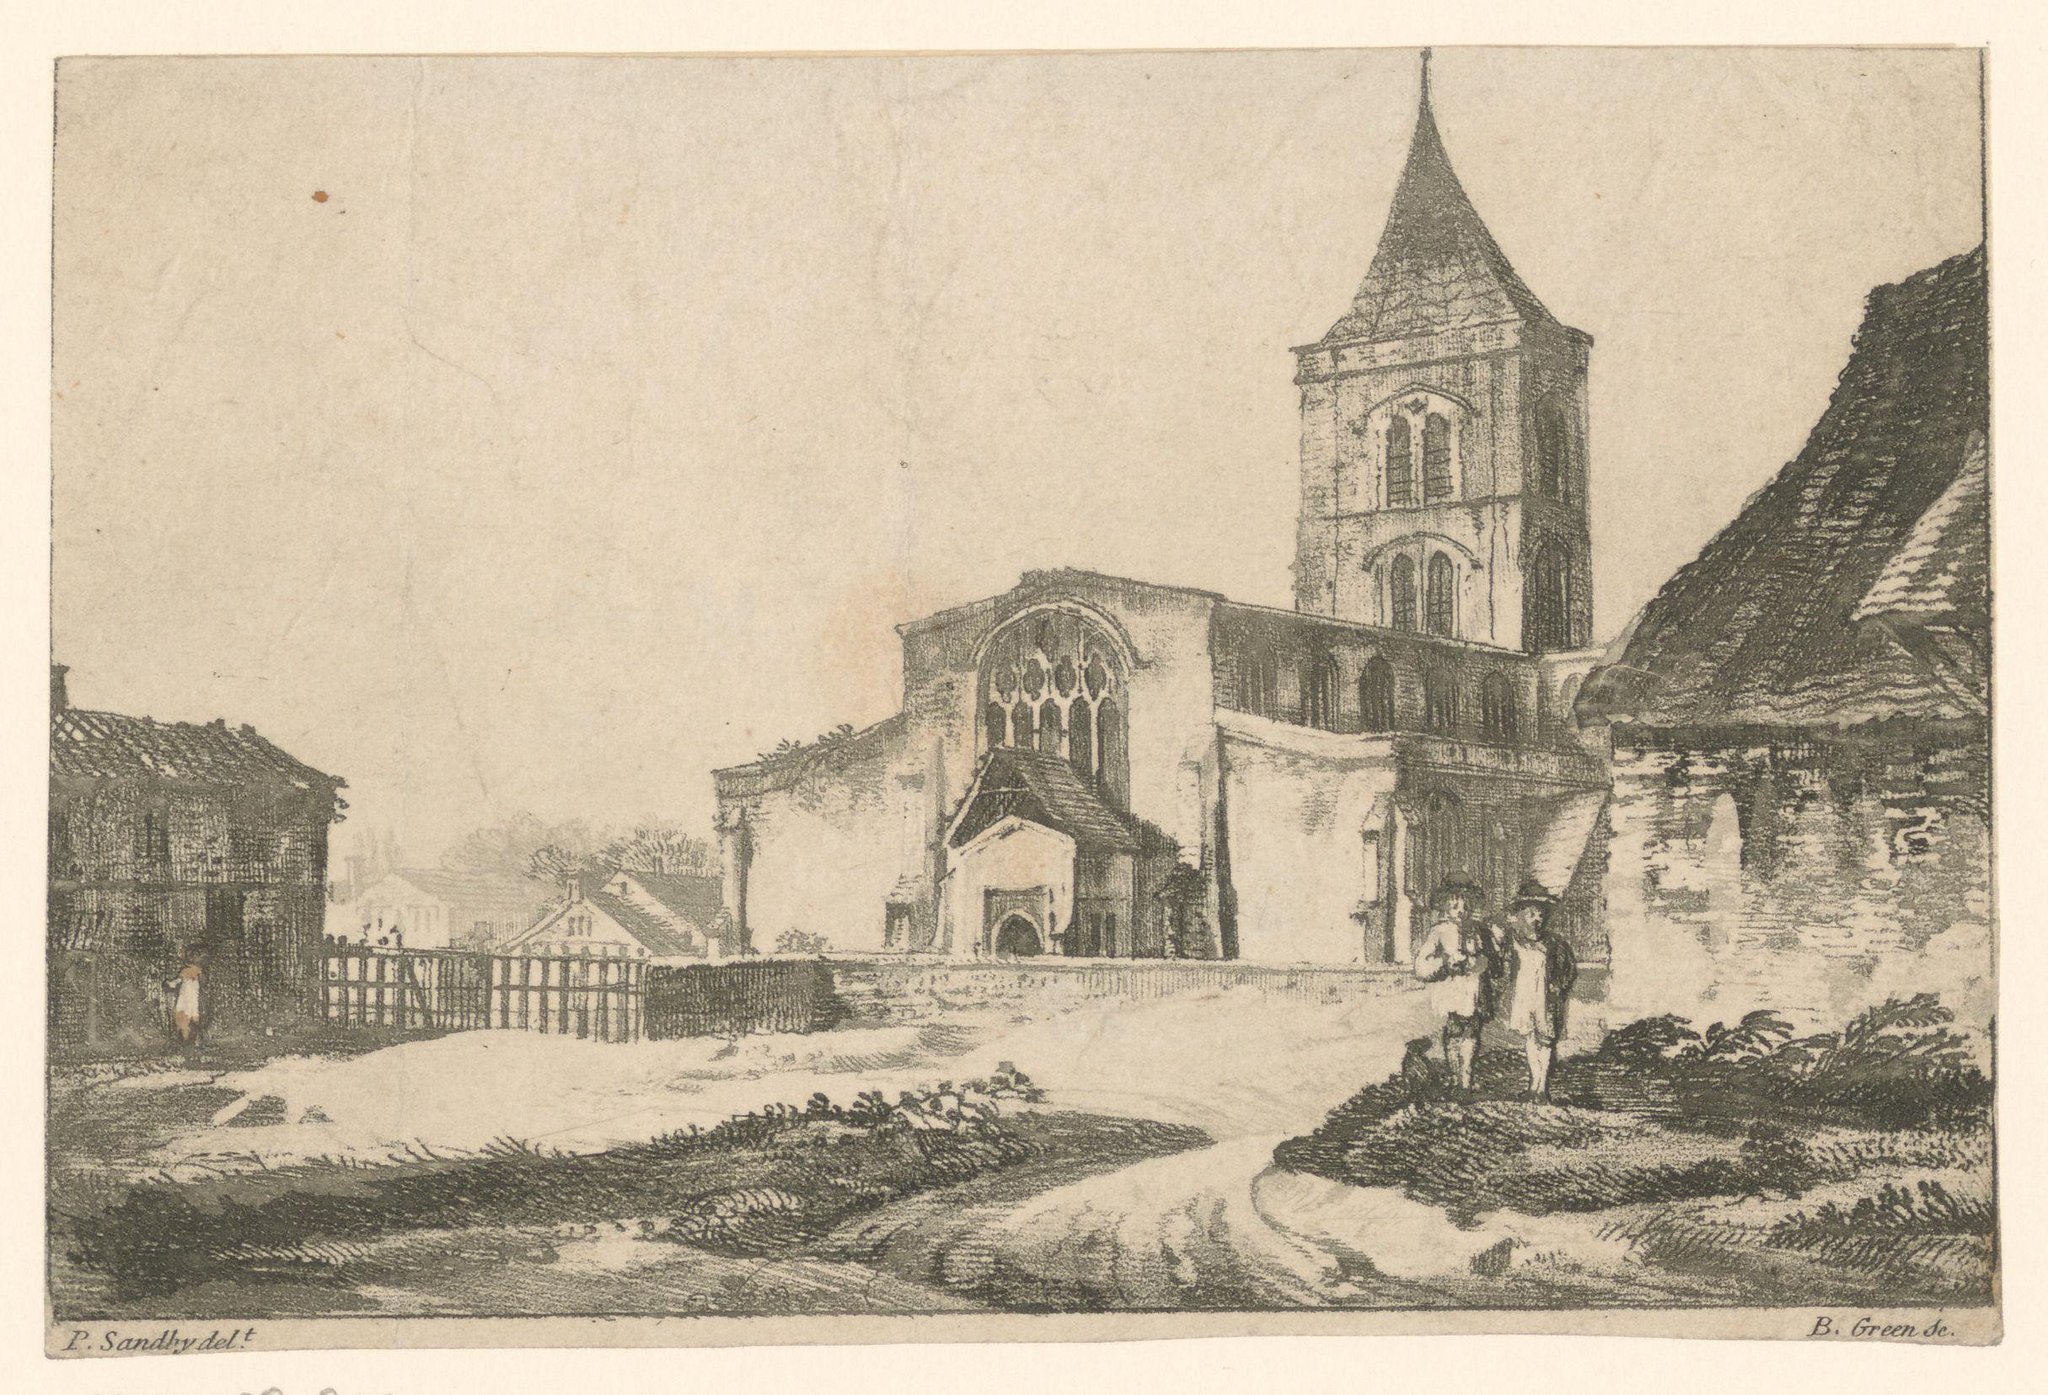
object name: print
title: Twee figuren staan voor de Sint Nicolaaskerk in Arundel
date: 1771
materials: paper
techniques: soft ground etching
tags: church (exterior)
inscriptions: collector's mark: Lugt 2228